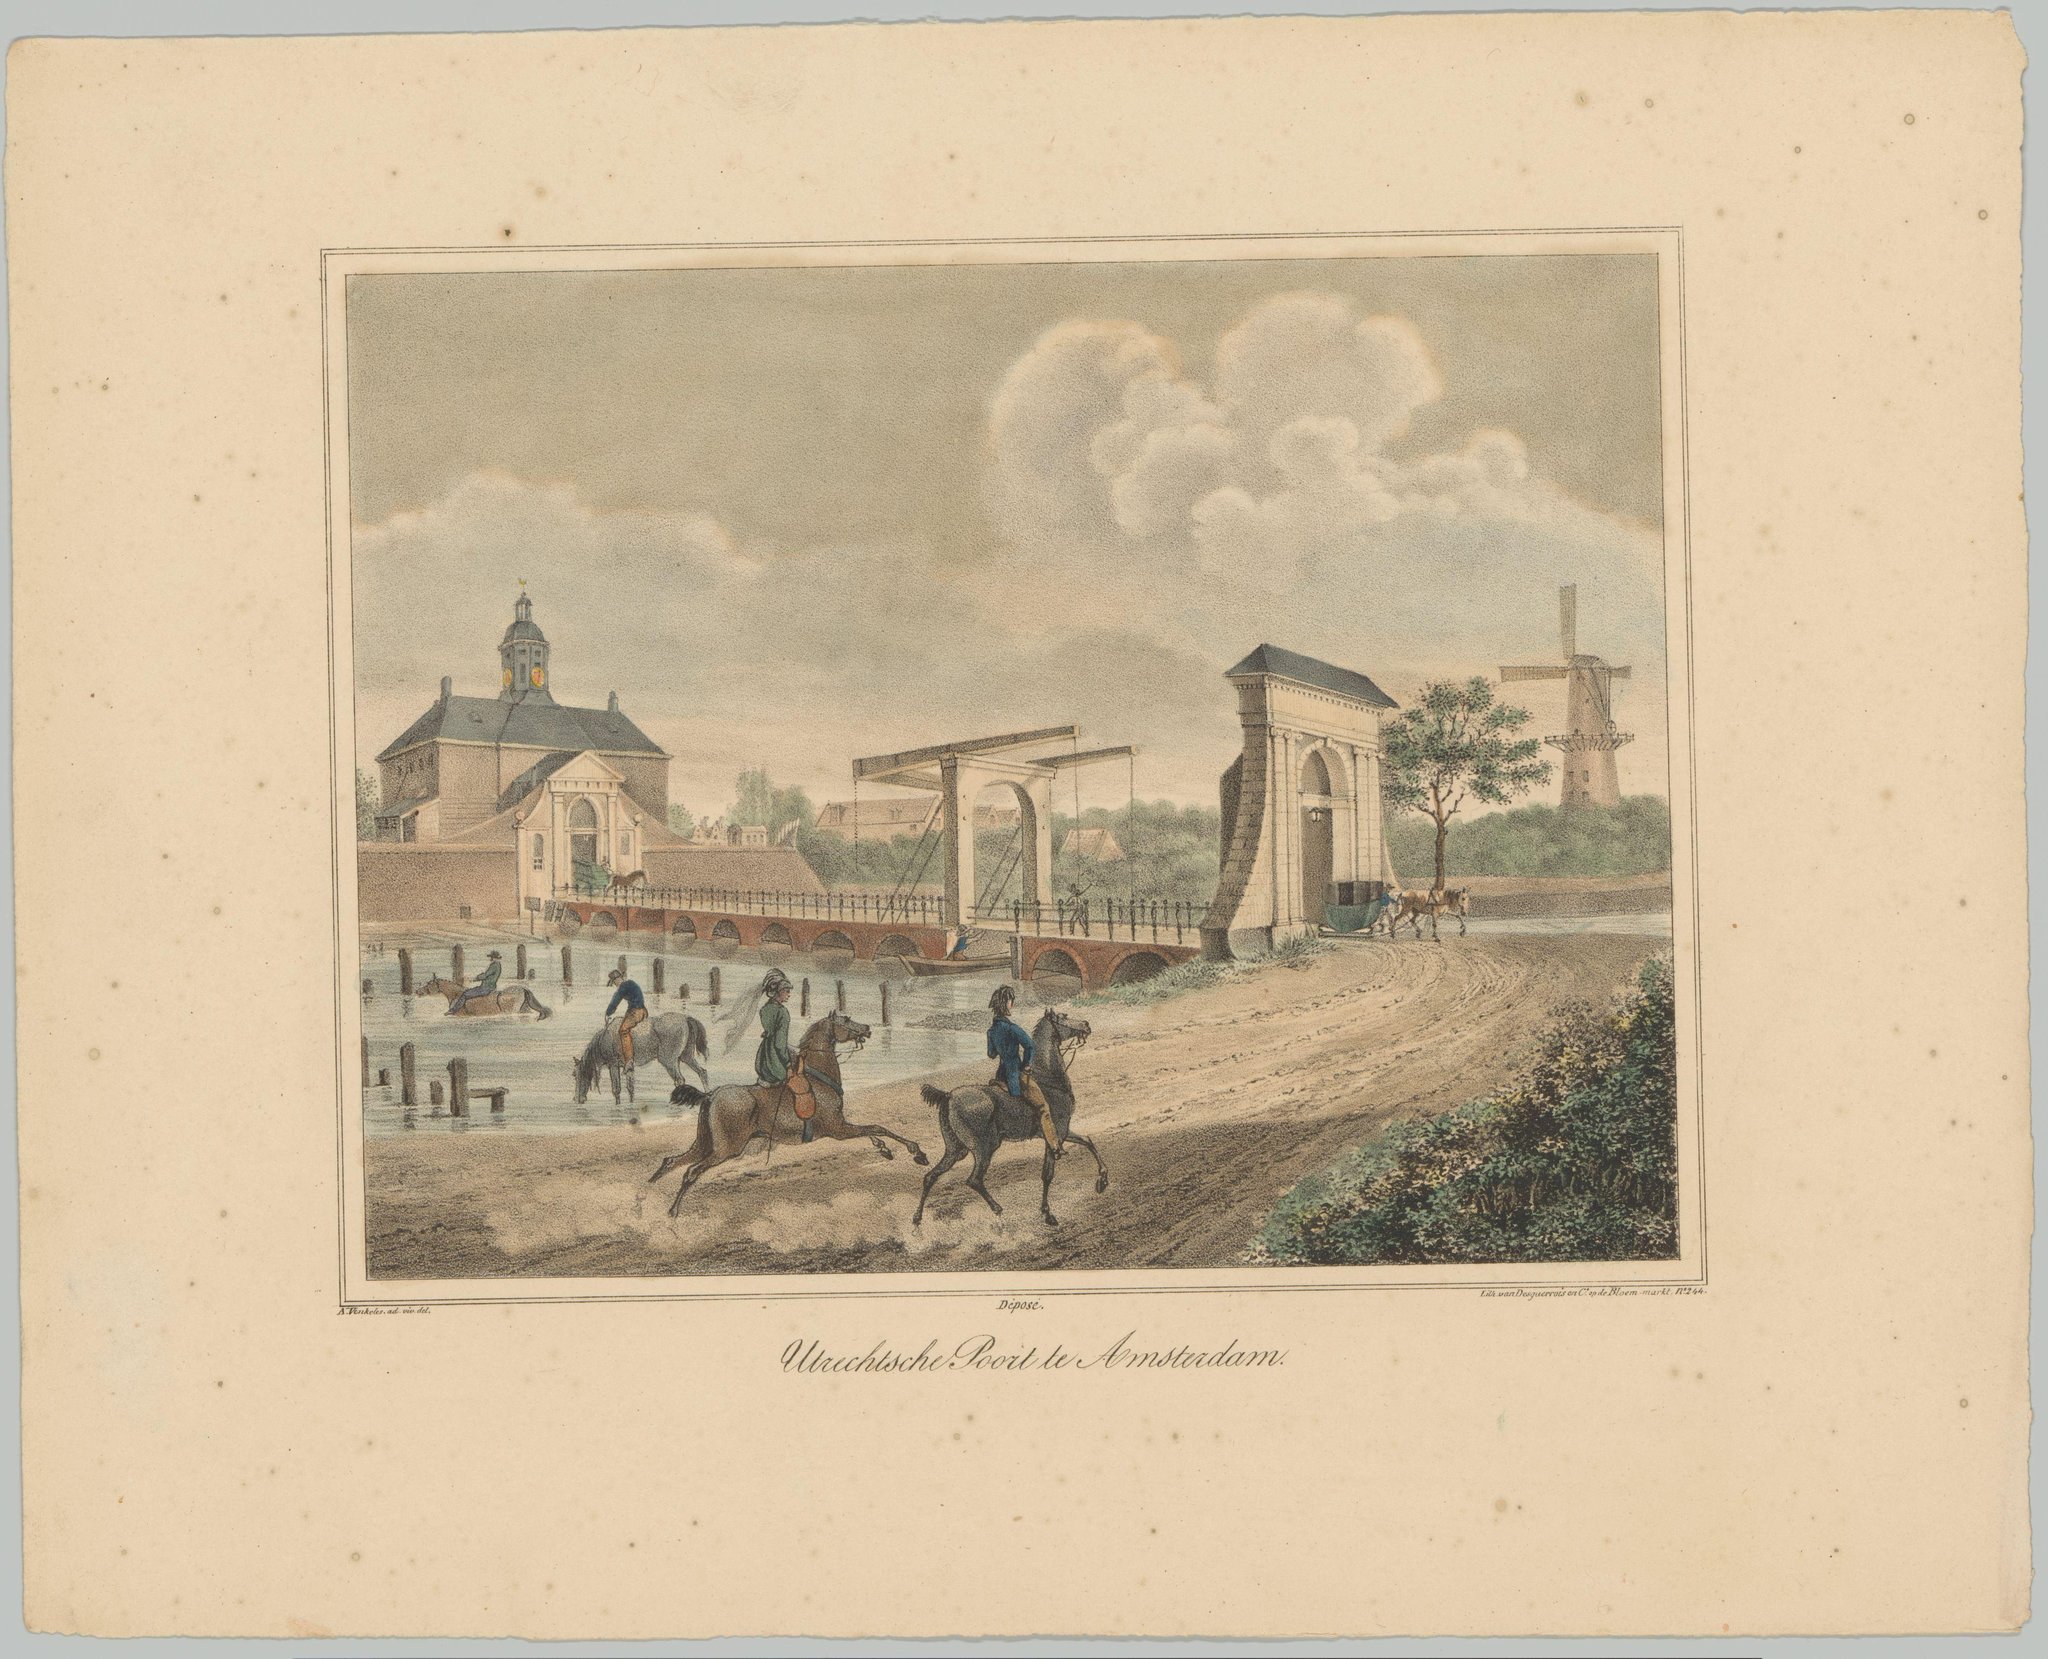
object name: print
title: Utrechtse Poort te Amsterdam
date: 1828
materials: paper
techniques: hand coloring, lithograph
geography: amsterdam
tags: gate, entrance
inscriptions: collector's mark: Lugt 2228, : ‘Déposé.’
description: Onderdeel van een omslag met een serie van zes lithografieën van Amsterdamse poorten.